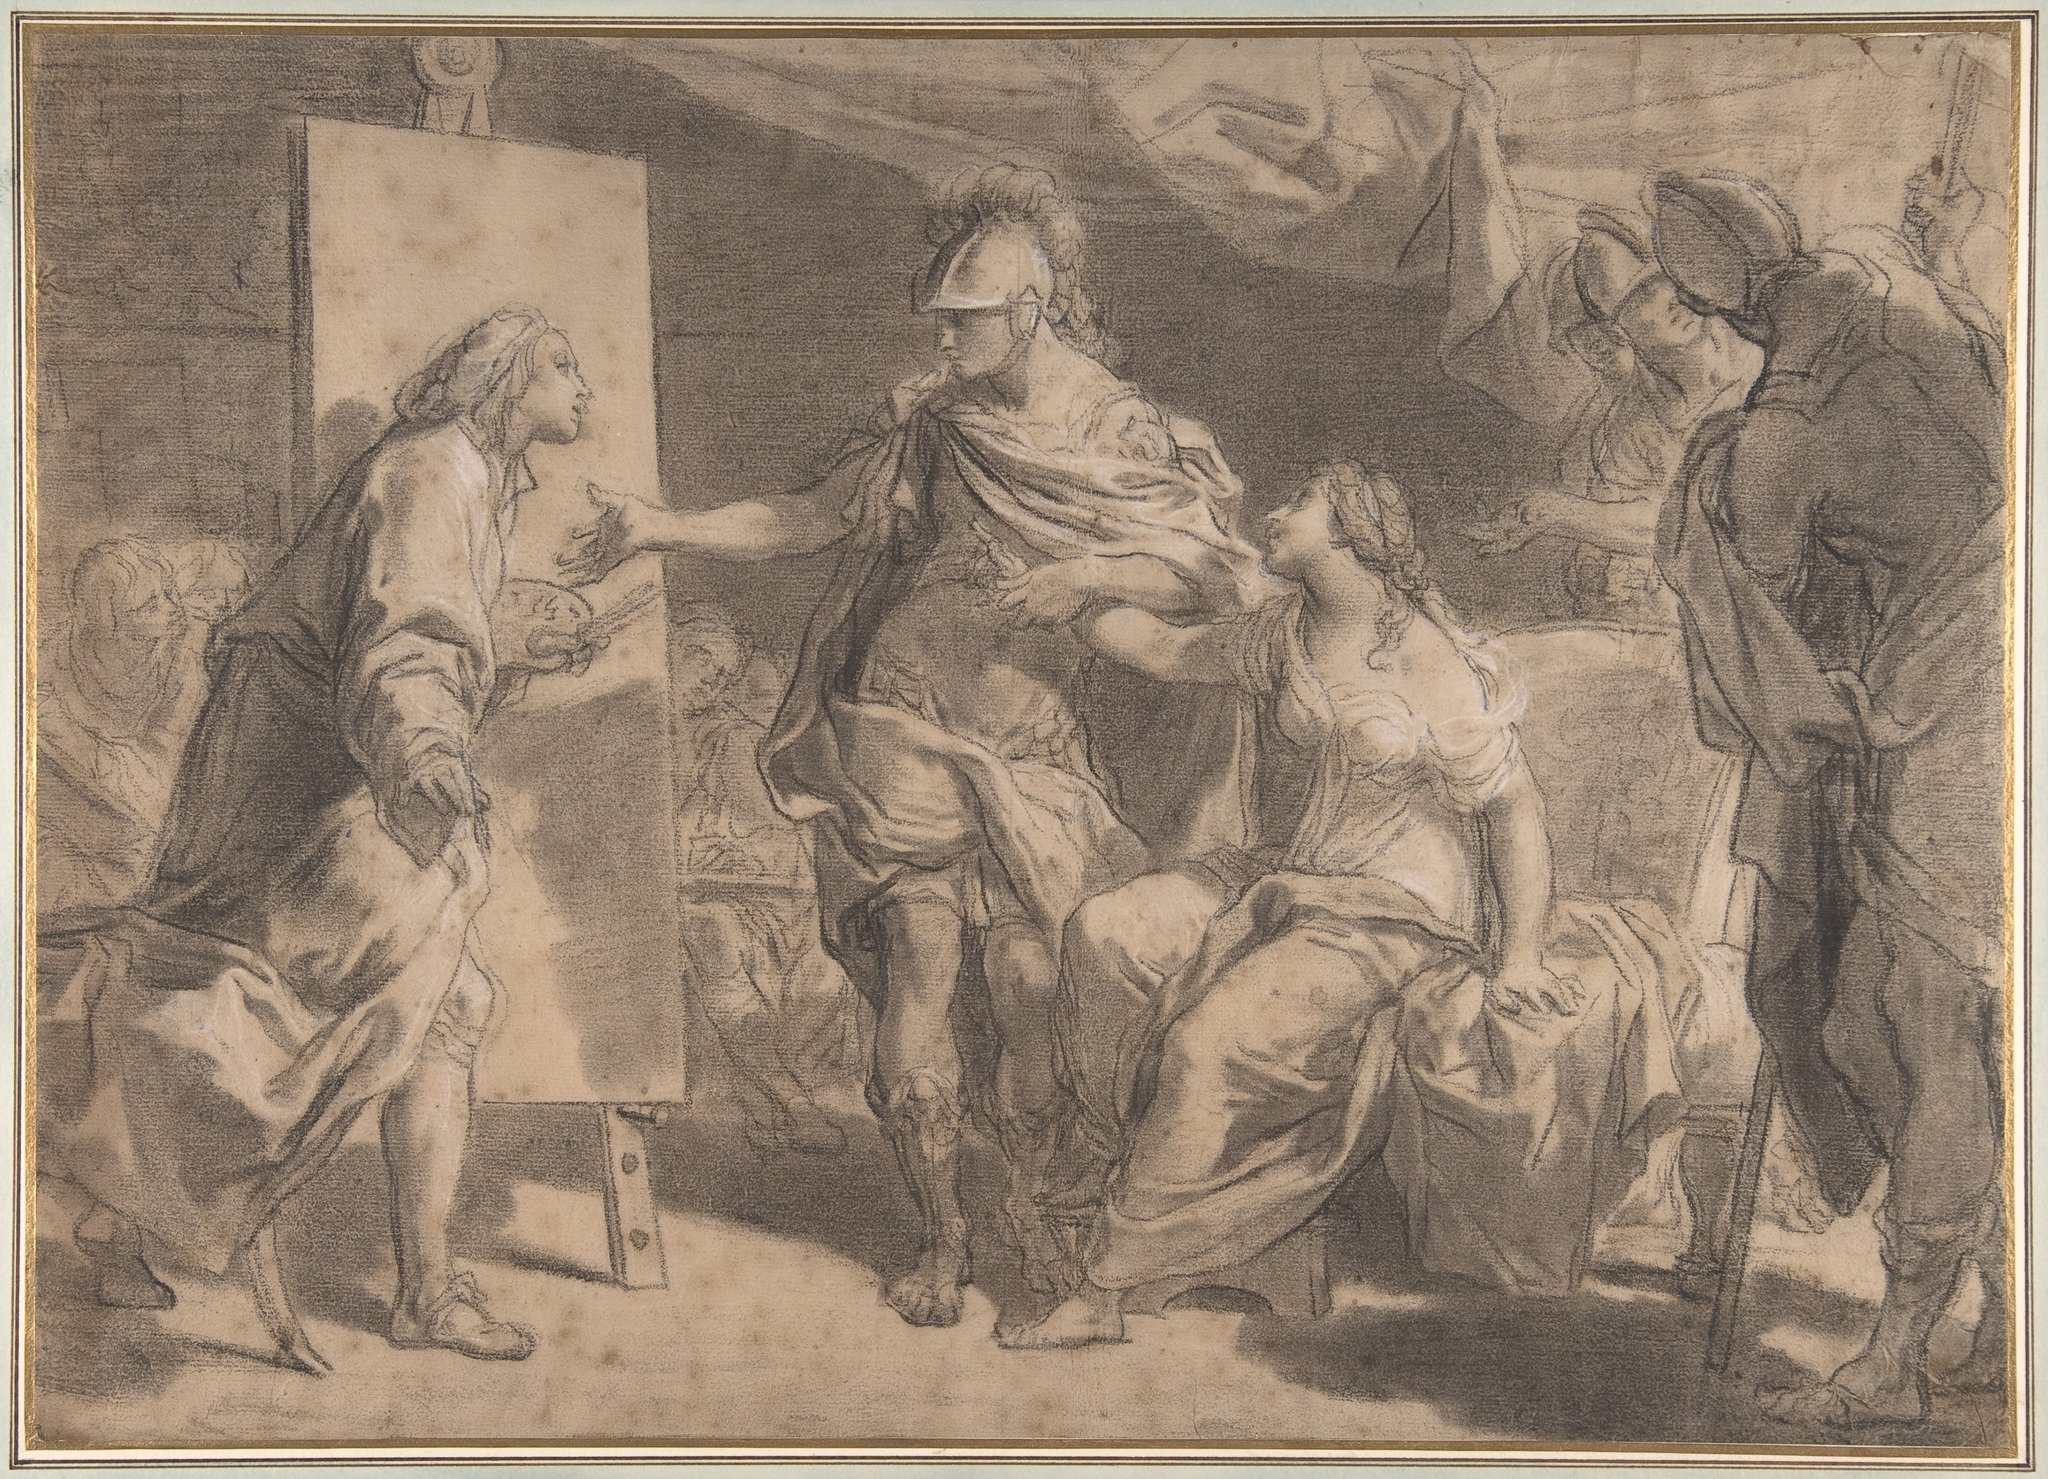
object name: drawing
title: Alexander the Great Offering His Concubine Campaspe to the Painter Apelles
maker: gaetano gandolfi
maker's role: artist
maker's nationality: italian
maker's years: 1734-1802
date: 1793-1797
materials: chalk, paper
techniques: highlighting, stumping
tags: alexander the great,men,women